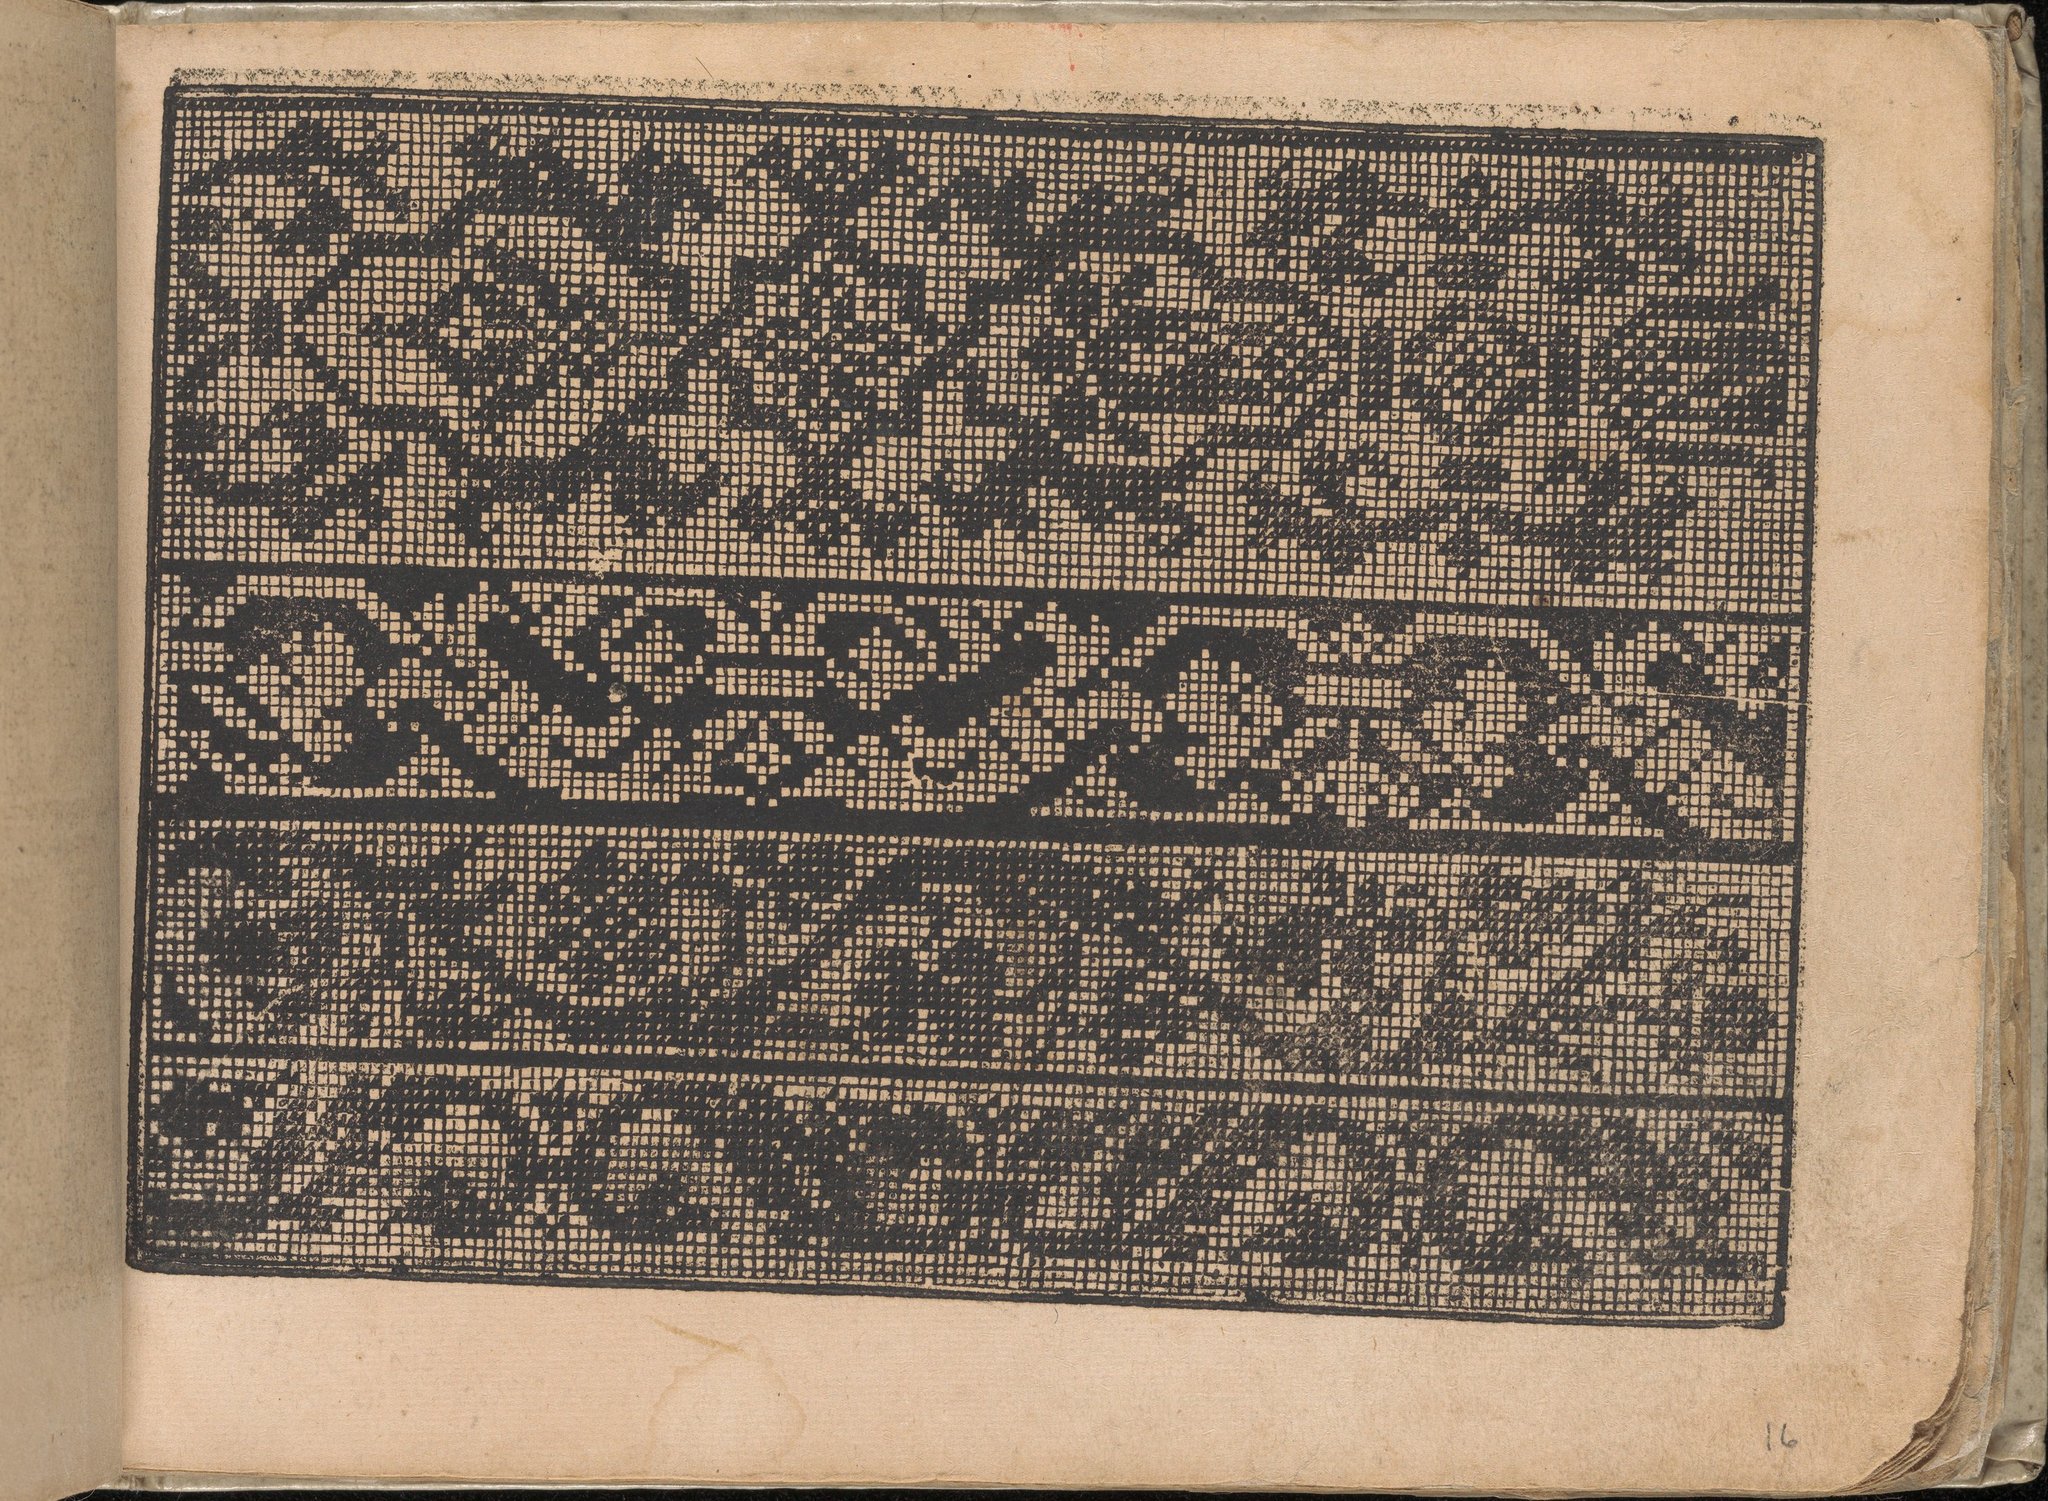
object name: book print ornament architecture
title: Neu künstlich Modelbuch (page 16r)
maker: bernhard jobin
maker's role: publisher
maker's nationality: swiss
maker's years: 1535-1597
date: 1598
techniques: woodcut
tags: flowers